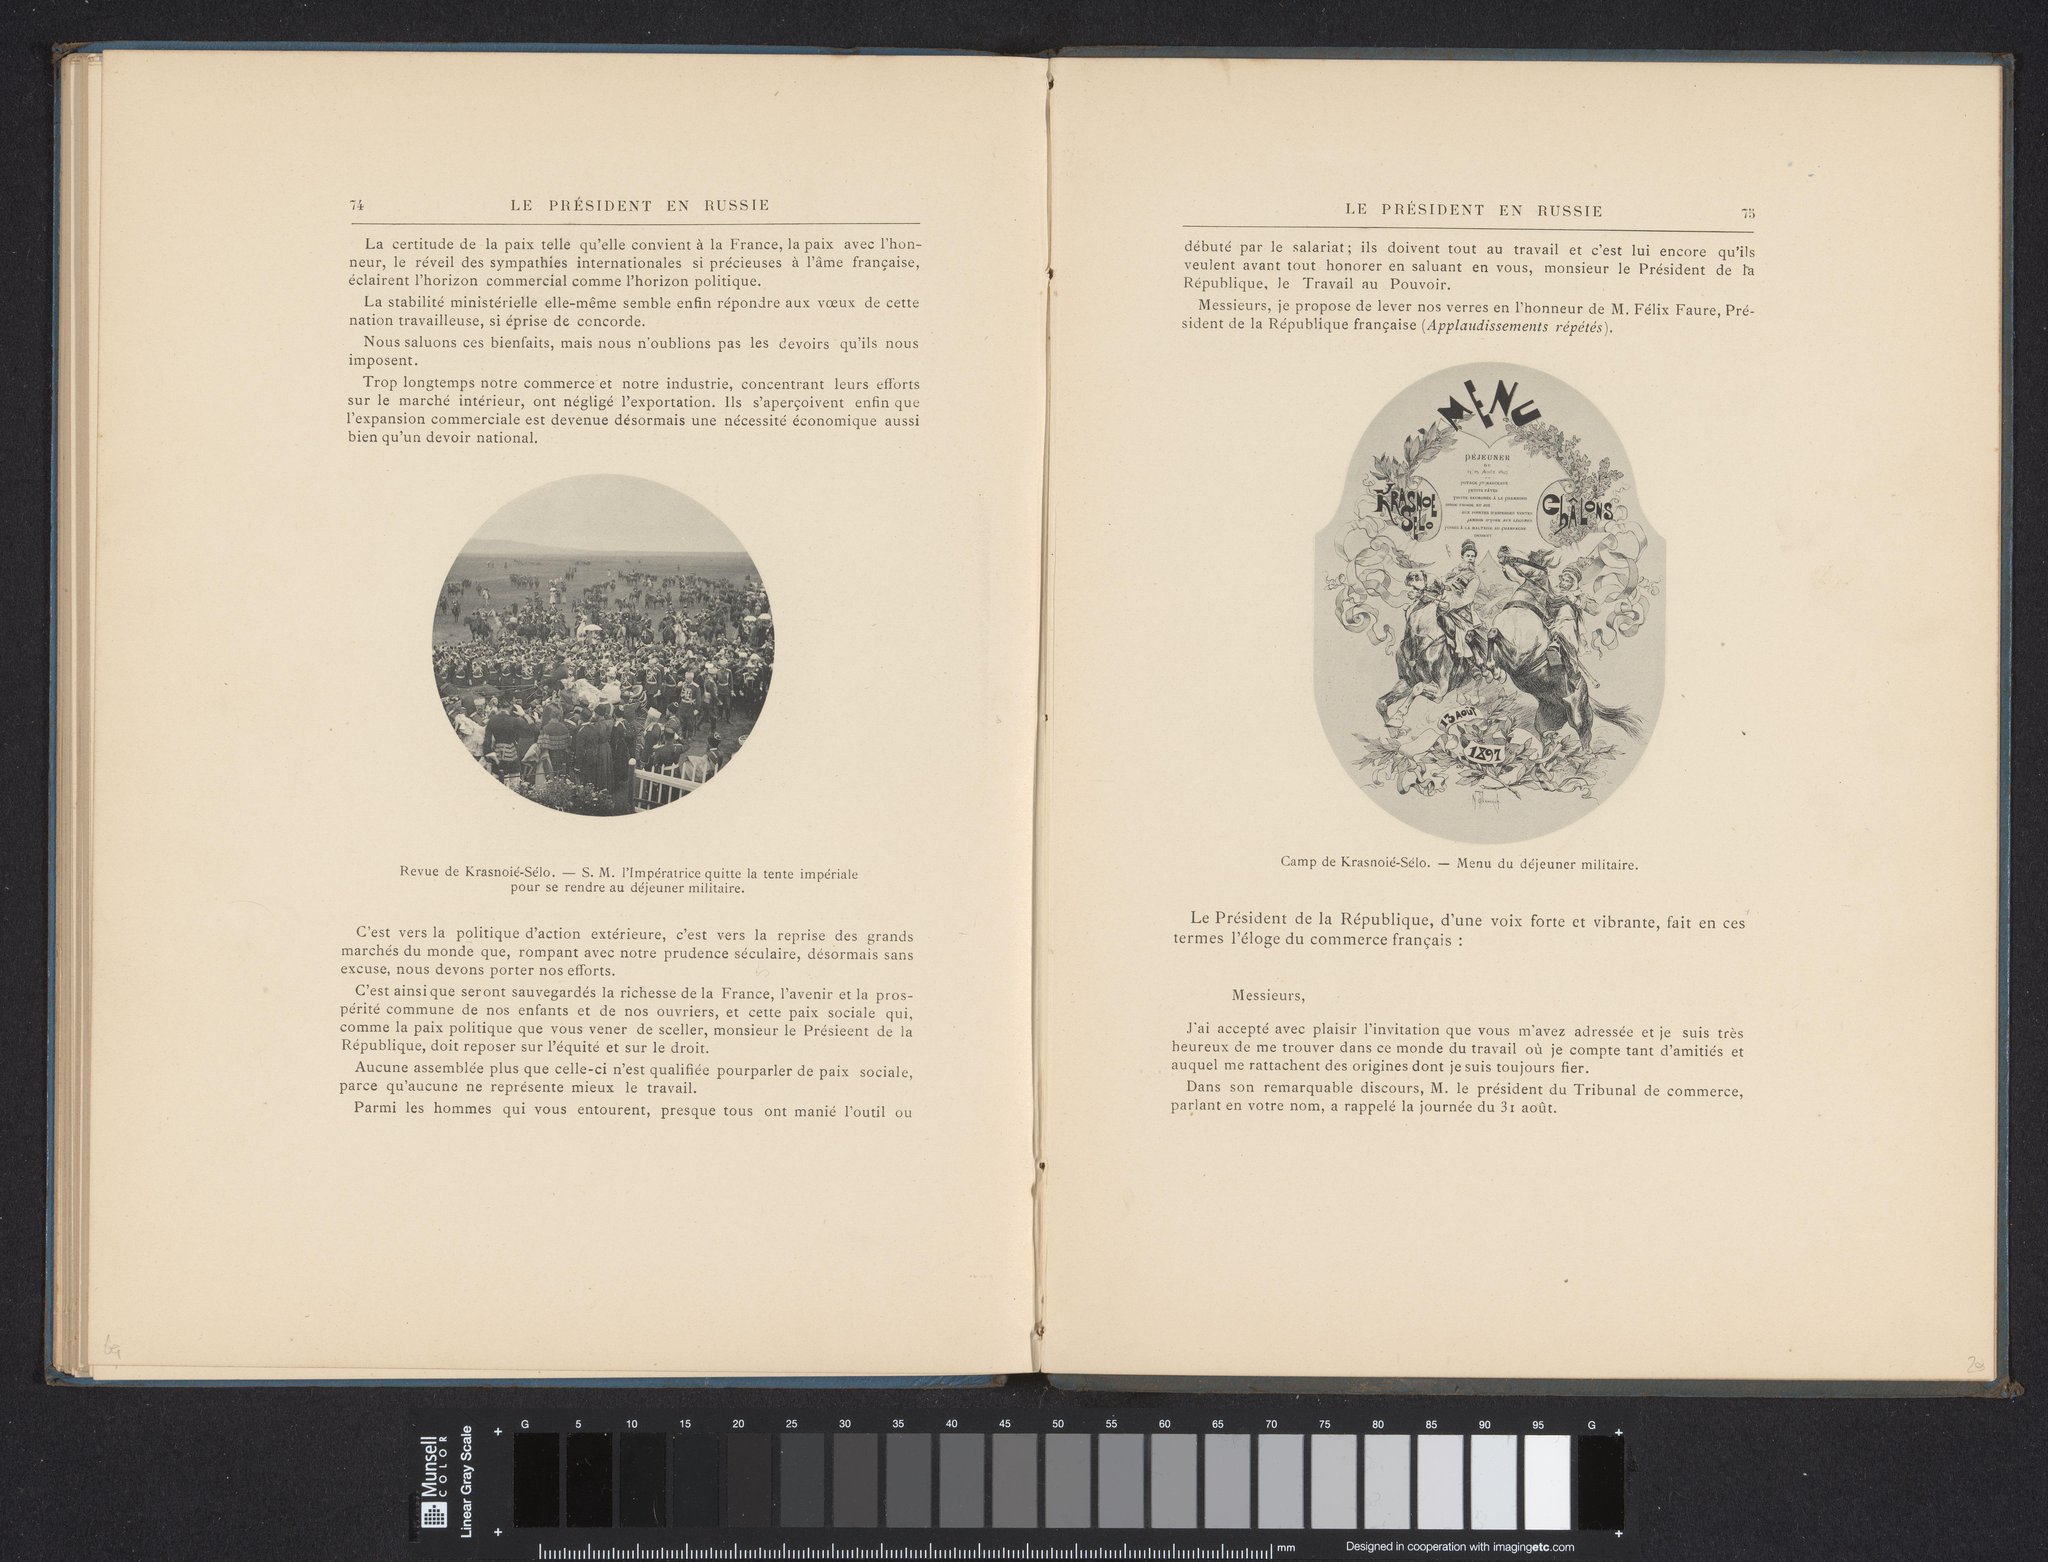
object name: photomechanical print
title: Tsarina Alexandra Fjodorovna van Rusland voegt zich bij een militaire lunch te Krasnoye Selo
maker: Anonymous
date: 1897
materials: paper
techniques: photograph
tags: ruler, sovereign - bb - female ruler, midday meal, lunch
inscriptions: inscription: ‘Revue de Krasnoié-Sélo-(...) militaire.’